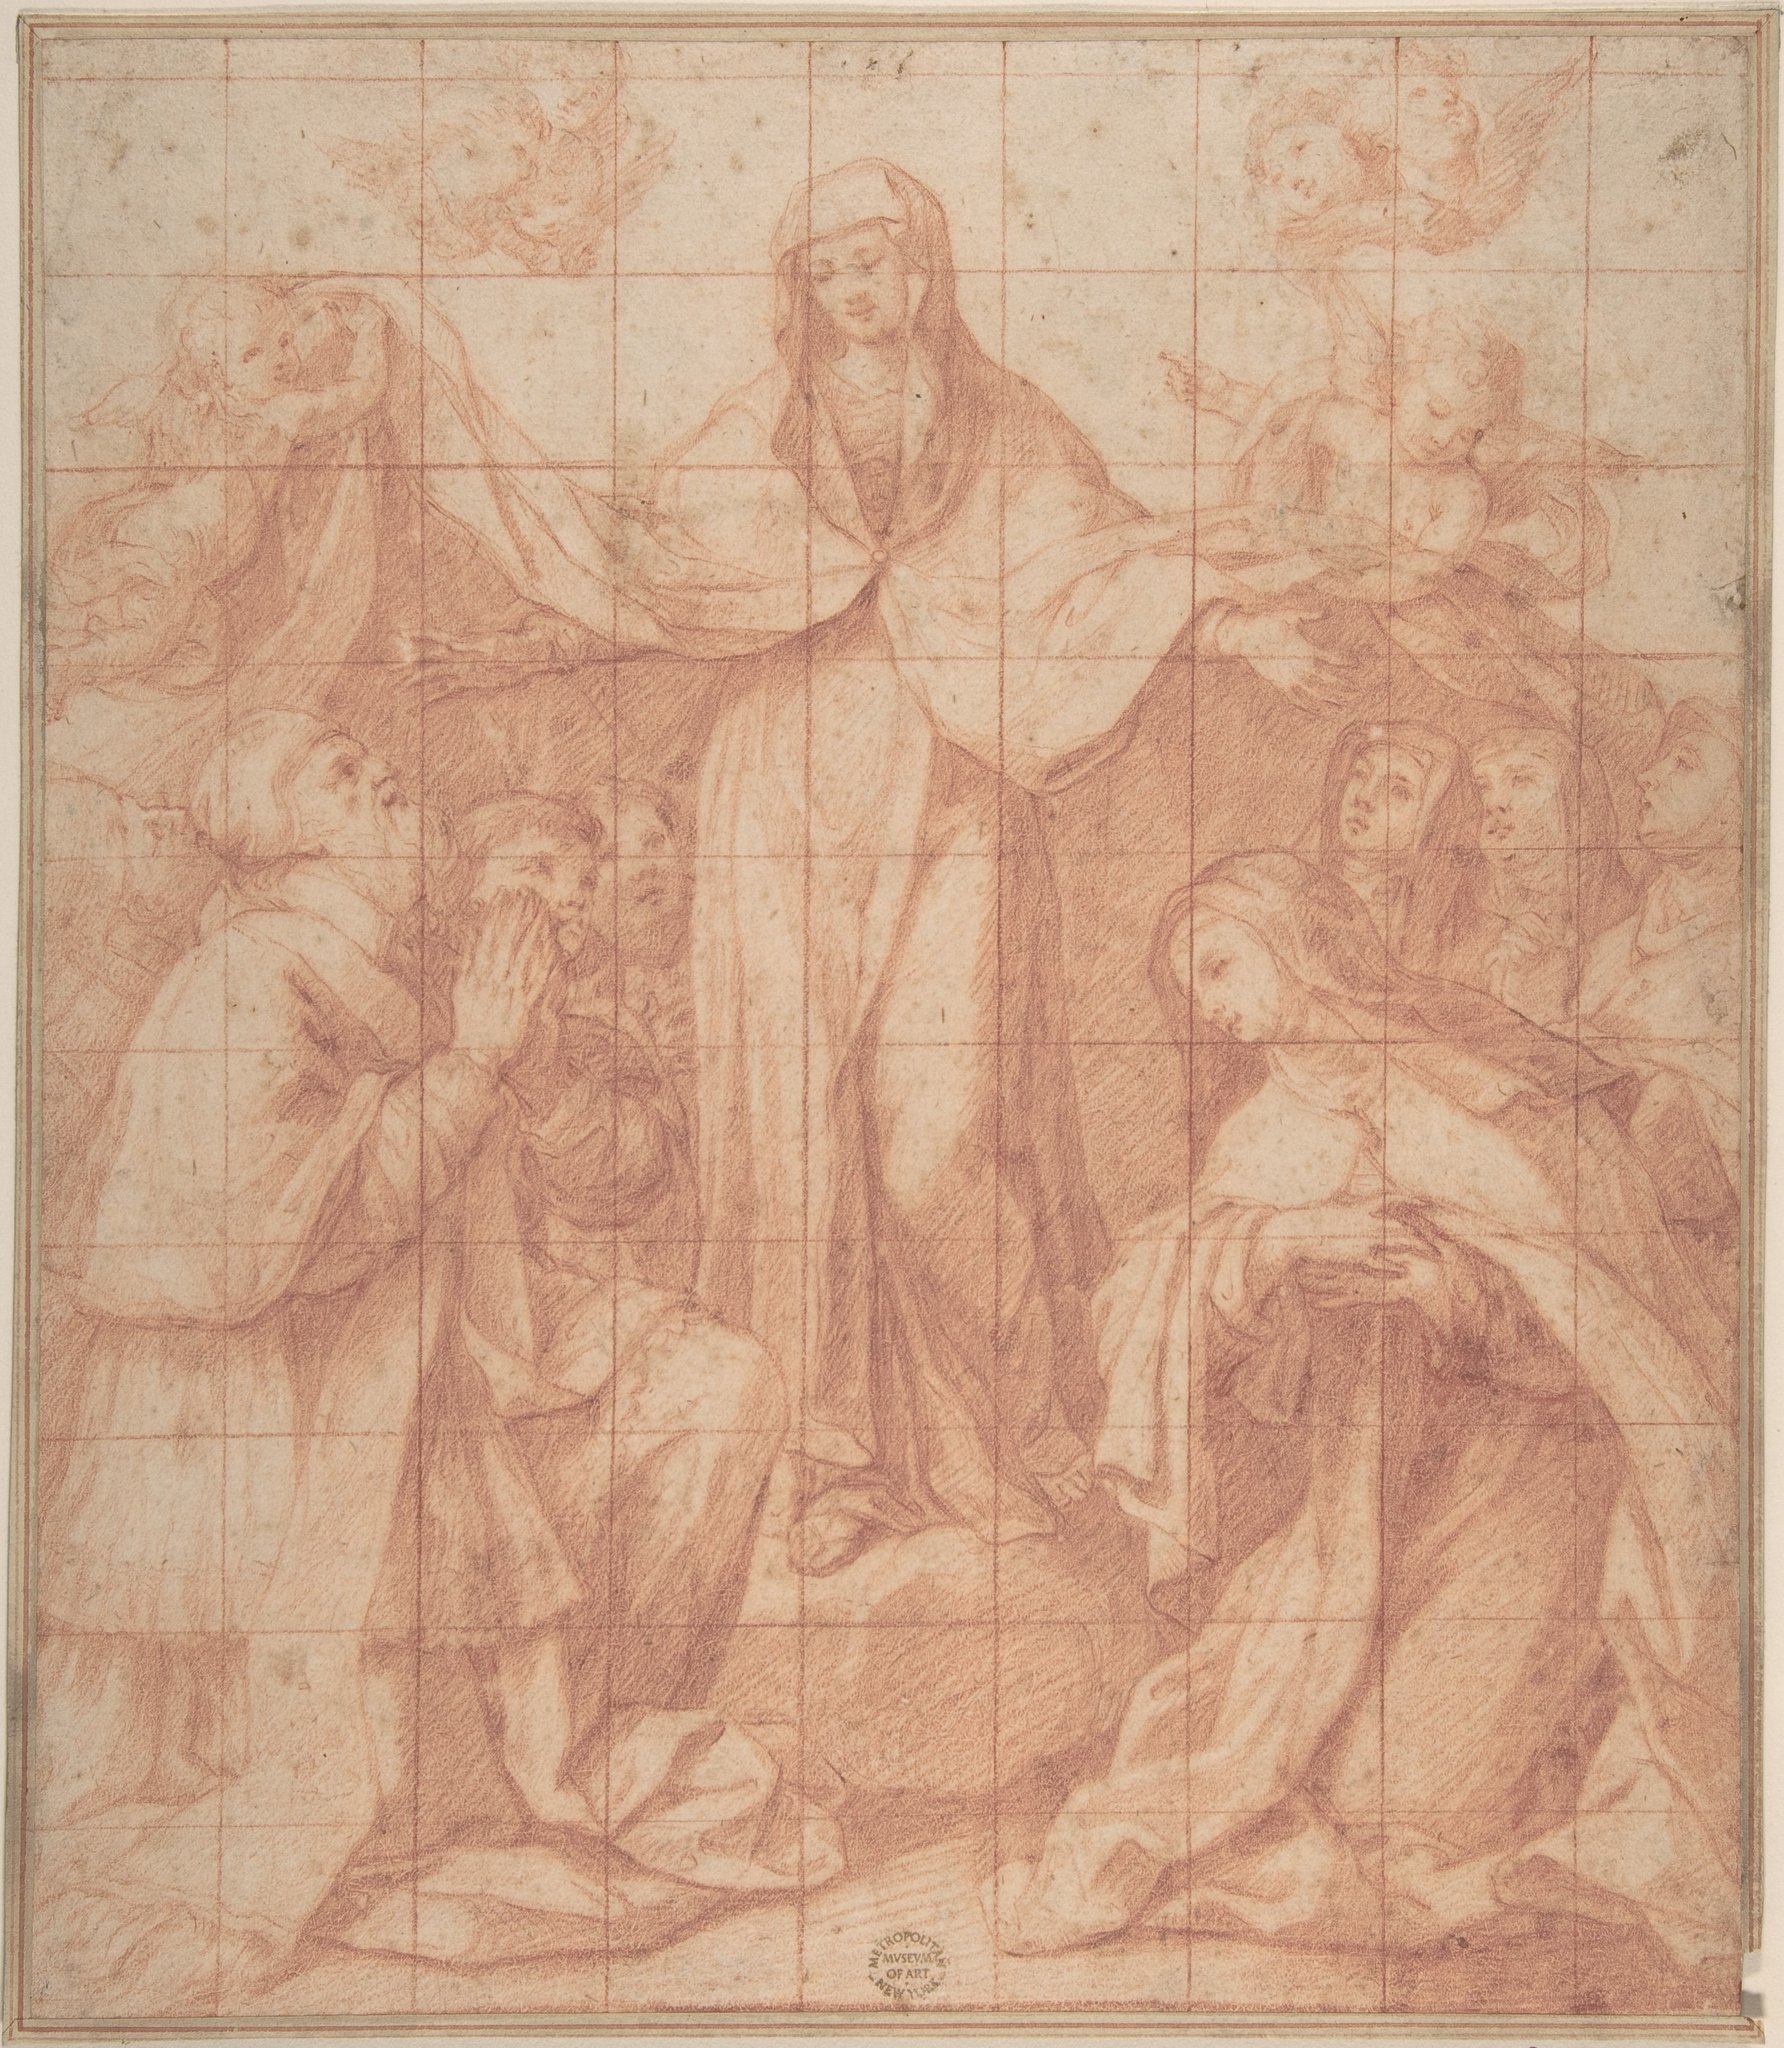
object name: drawing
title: Madonna of Mercy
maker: anonymous, italian, roman-bolognese, 17th century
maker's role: artist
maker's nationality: italian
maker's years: 1600-1700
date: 1601-1700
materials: chalk, paper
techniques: drawing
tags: men,women,angels,madonna